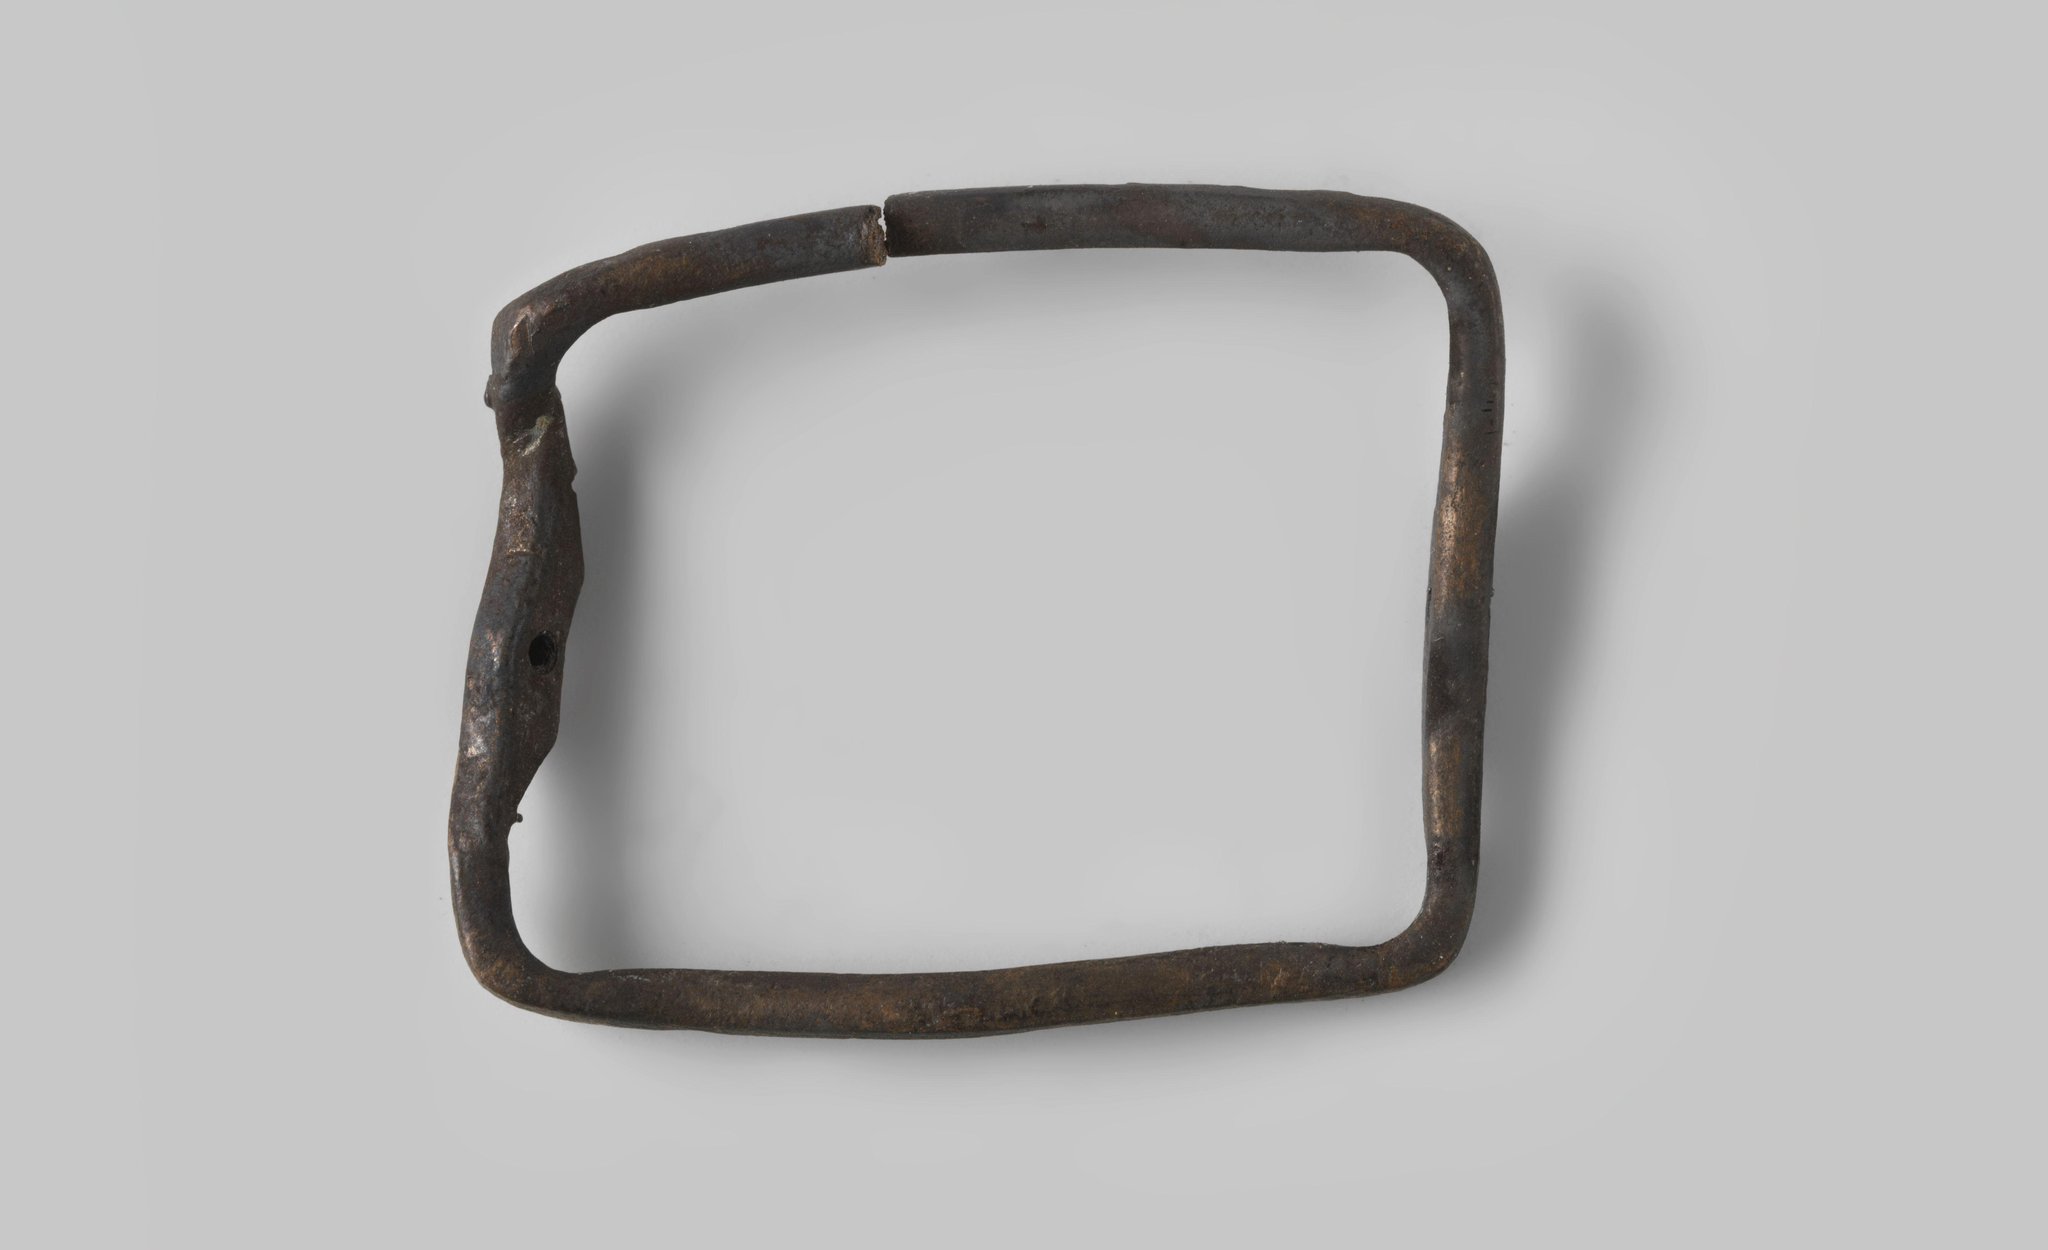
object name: knee buckle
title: Kniegesp uit het wrak van de Oost-Indiëvaarder Hollandia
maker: Anonymous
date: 1700-1743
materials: copper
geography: netherlands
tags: verenigde oostindische compagnie, hollandia (schip), annet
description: Buckle, chape buckle, knee buckle; ring, rectangular outline, relieved decoration of check motif (spindle longitudinal).